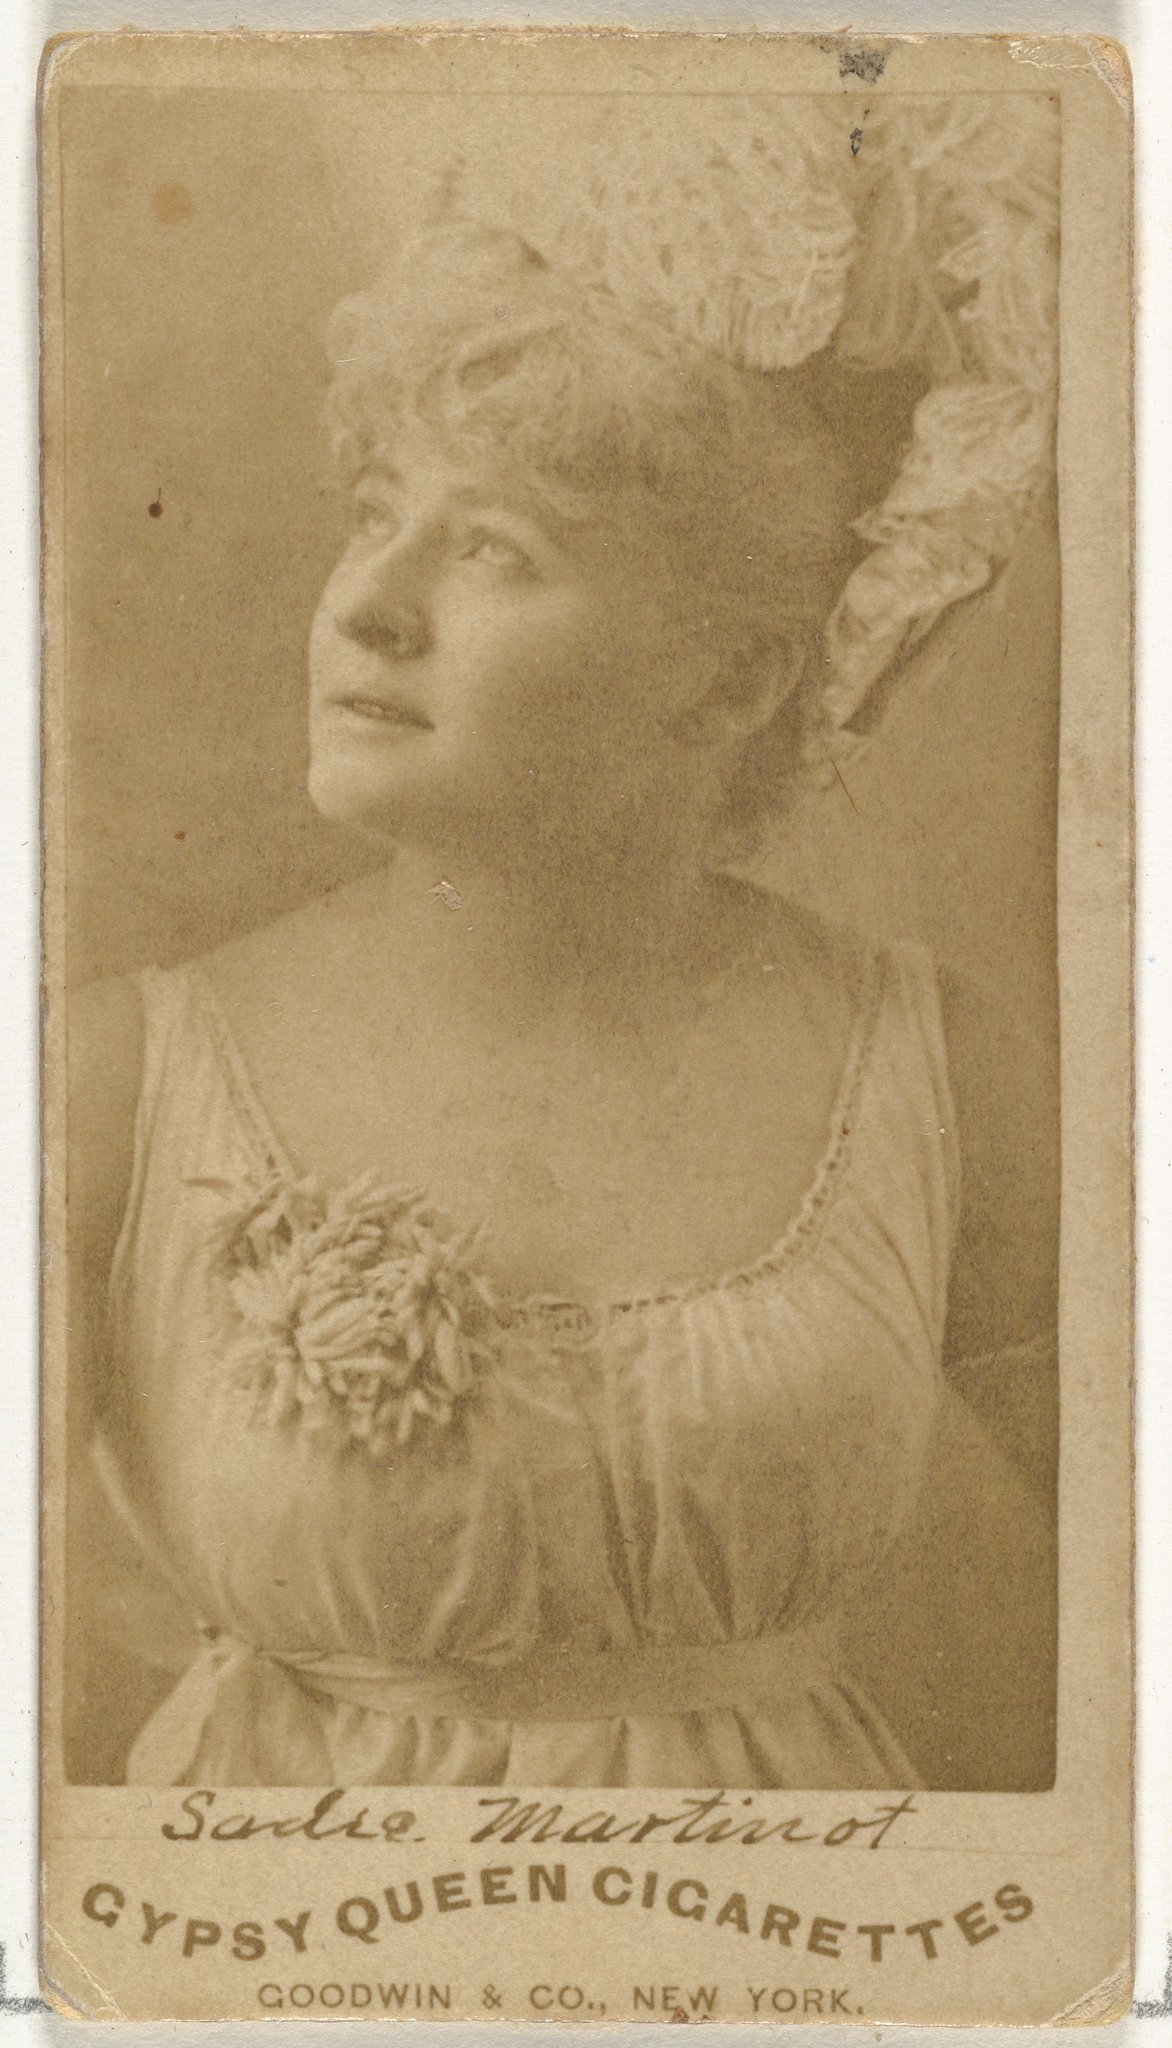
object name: photograph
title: Sadie Martinot, from the Actors and Actresses series (N171) for Gypsy Queen Cigarettes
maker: goodwin & company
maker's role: publisher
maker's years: 1850-1950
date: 1886-1890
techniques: albumen silver print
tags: portraits,women,actresses